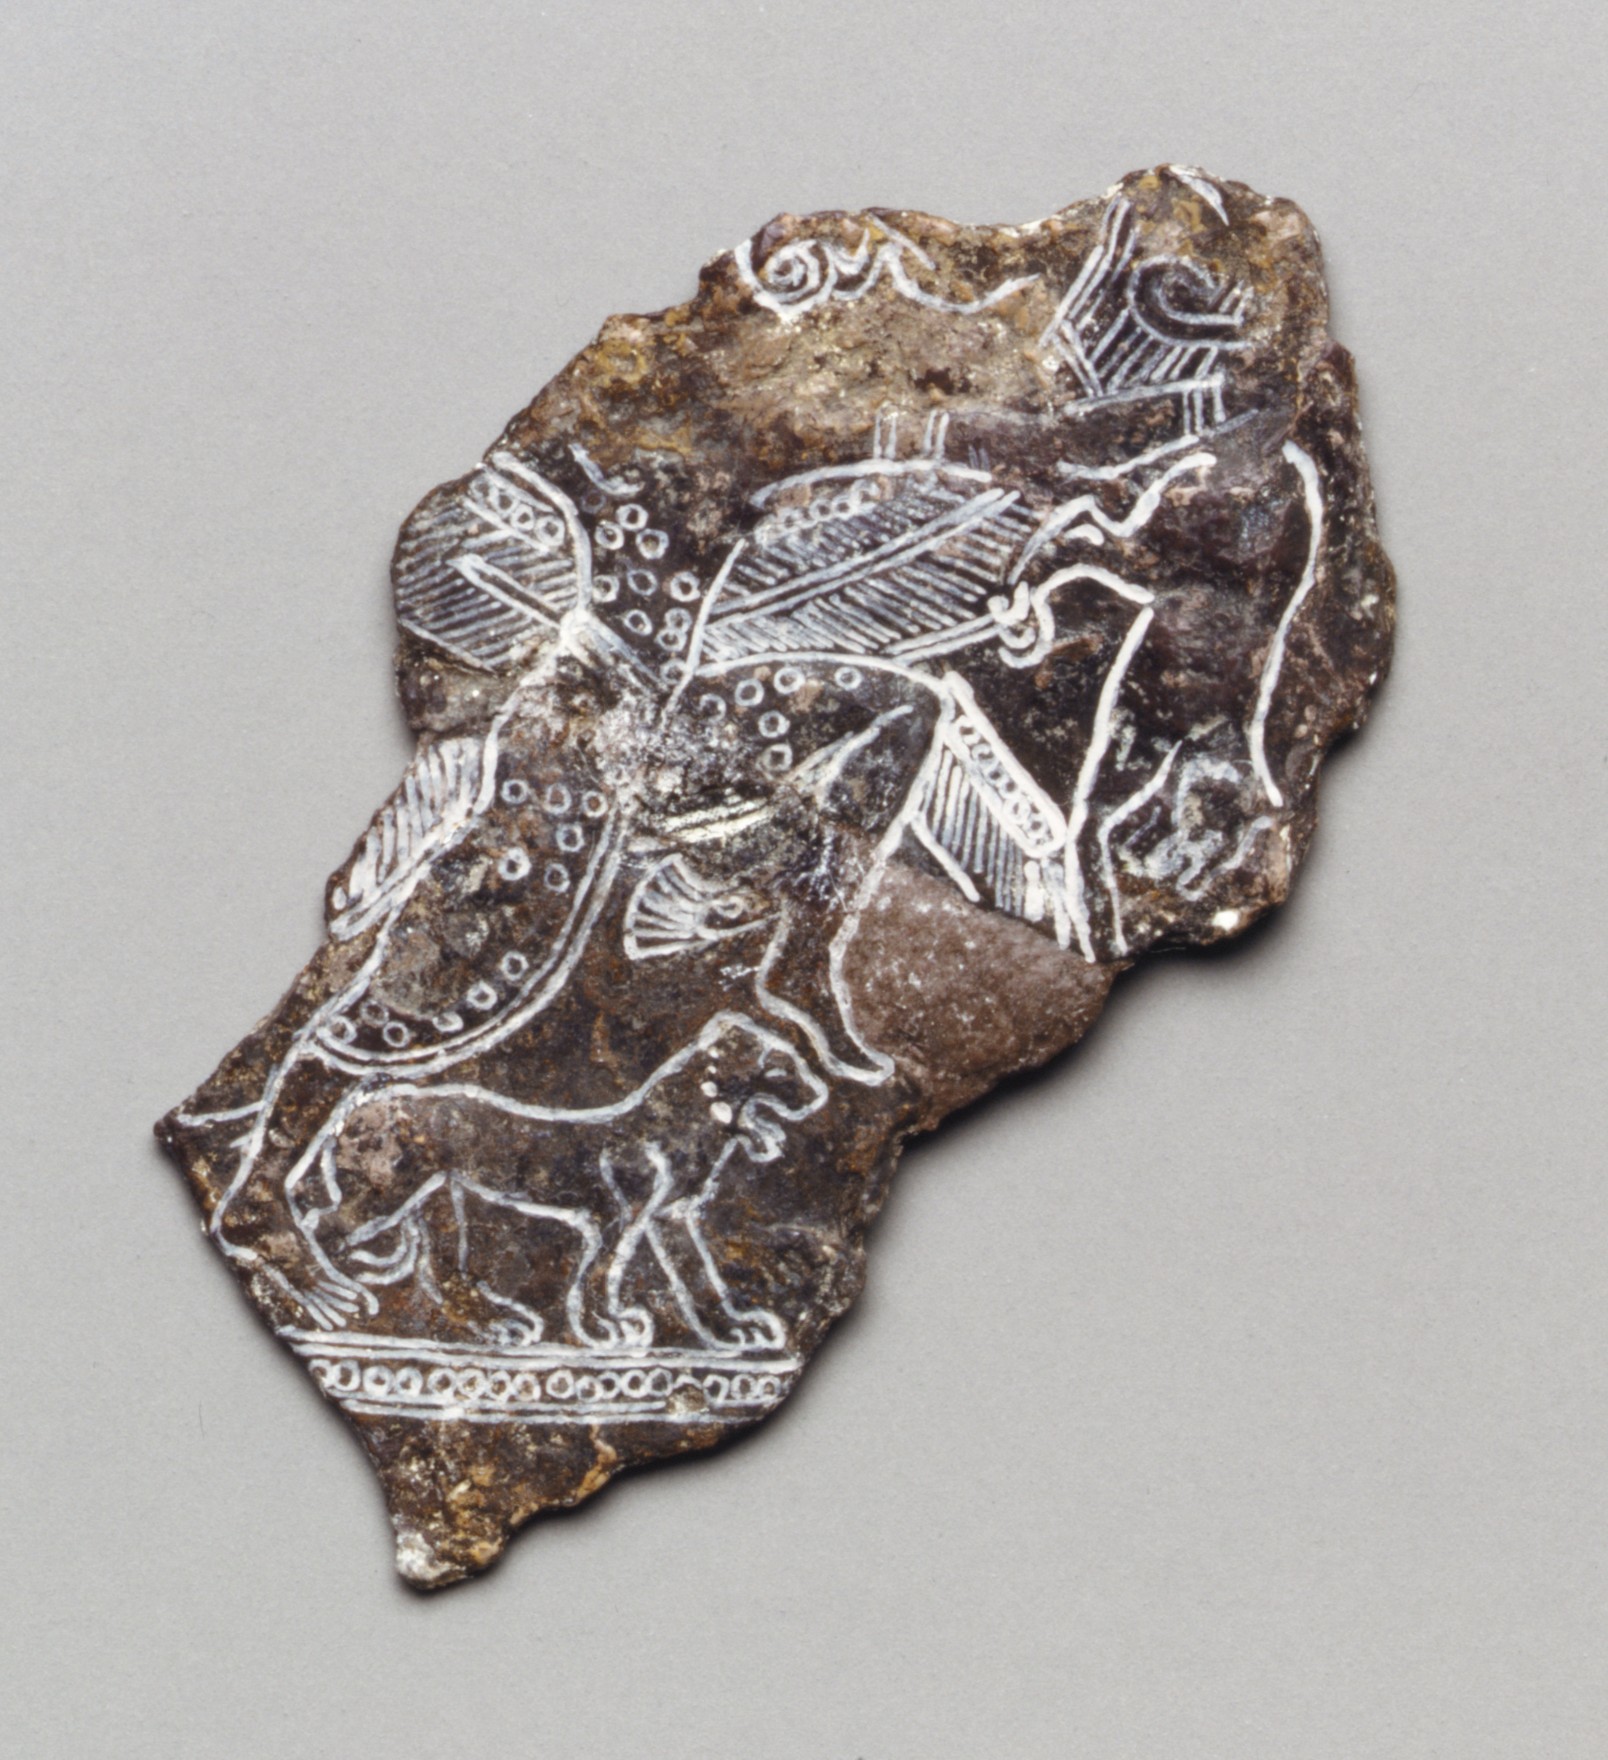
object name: fragment of a bowl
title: Fragment of a silver bowl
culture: cypriot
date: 700-601 BCE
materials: silver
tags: lions